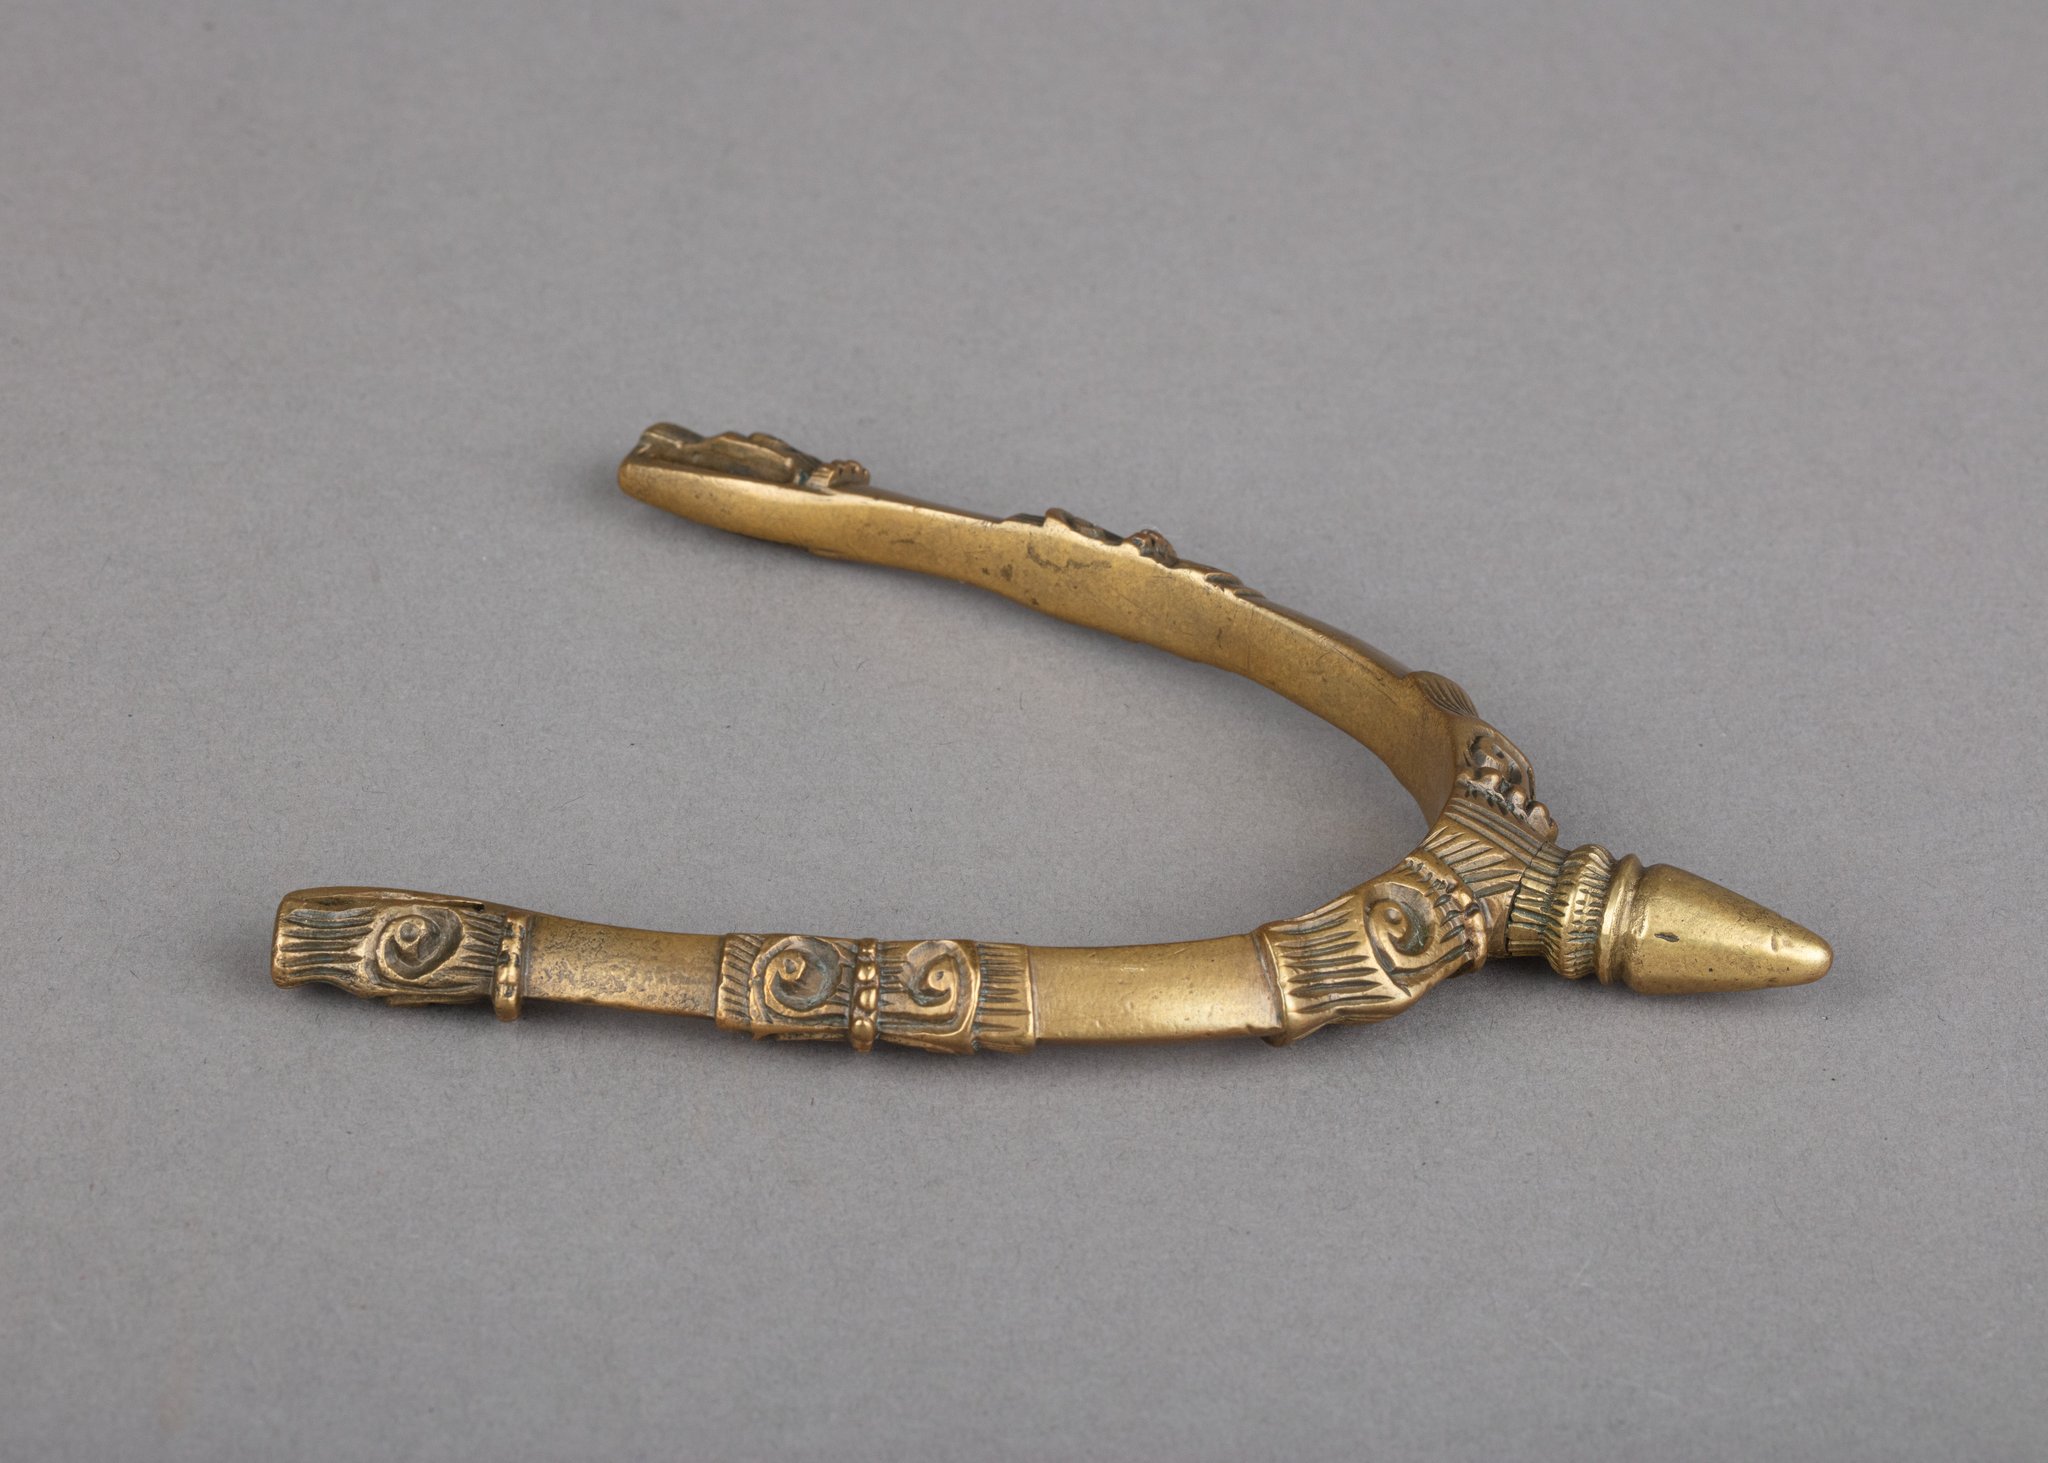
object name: spur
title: Prick Spur in the Style of the 8th Century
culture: german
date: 1801-1900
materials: copper alloy